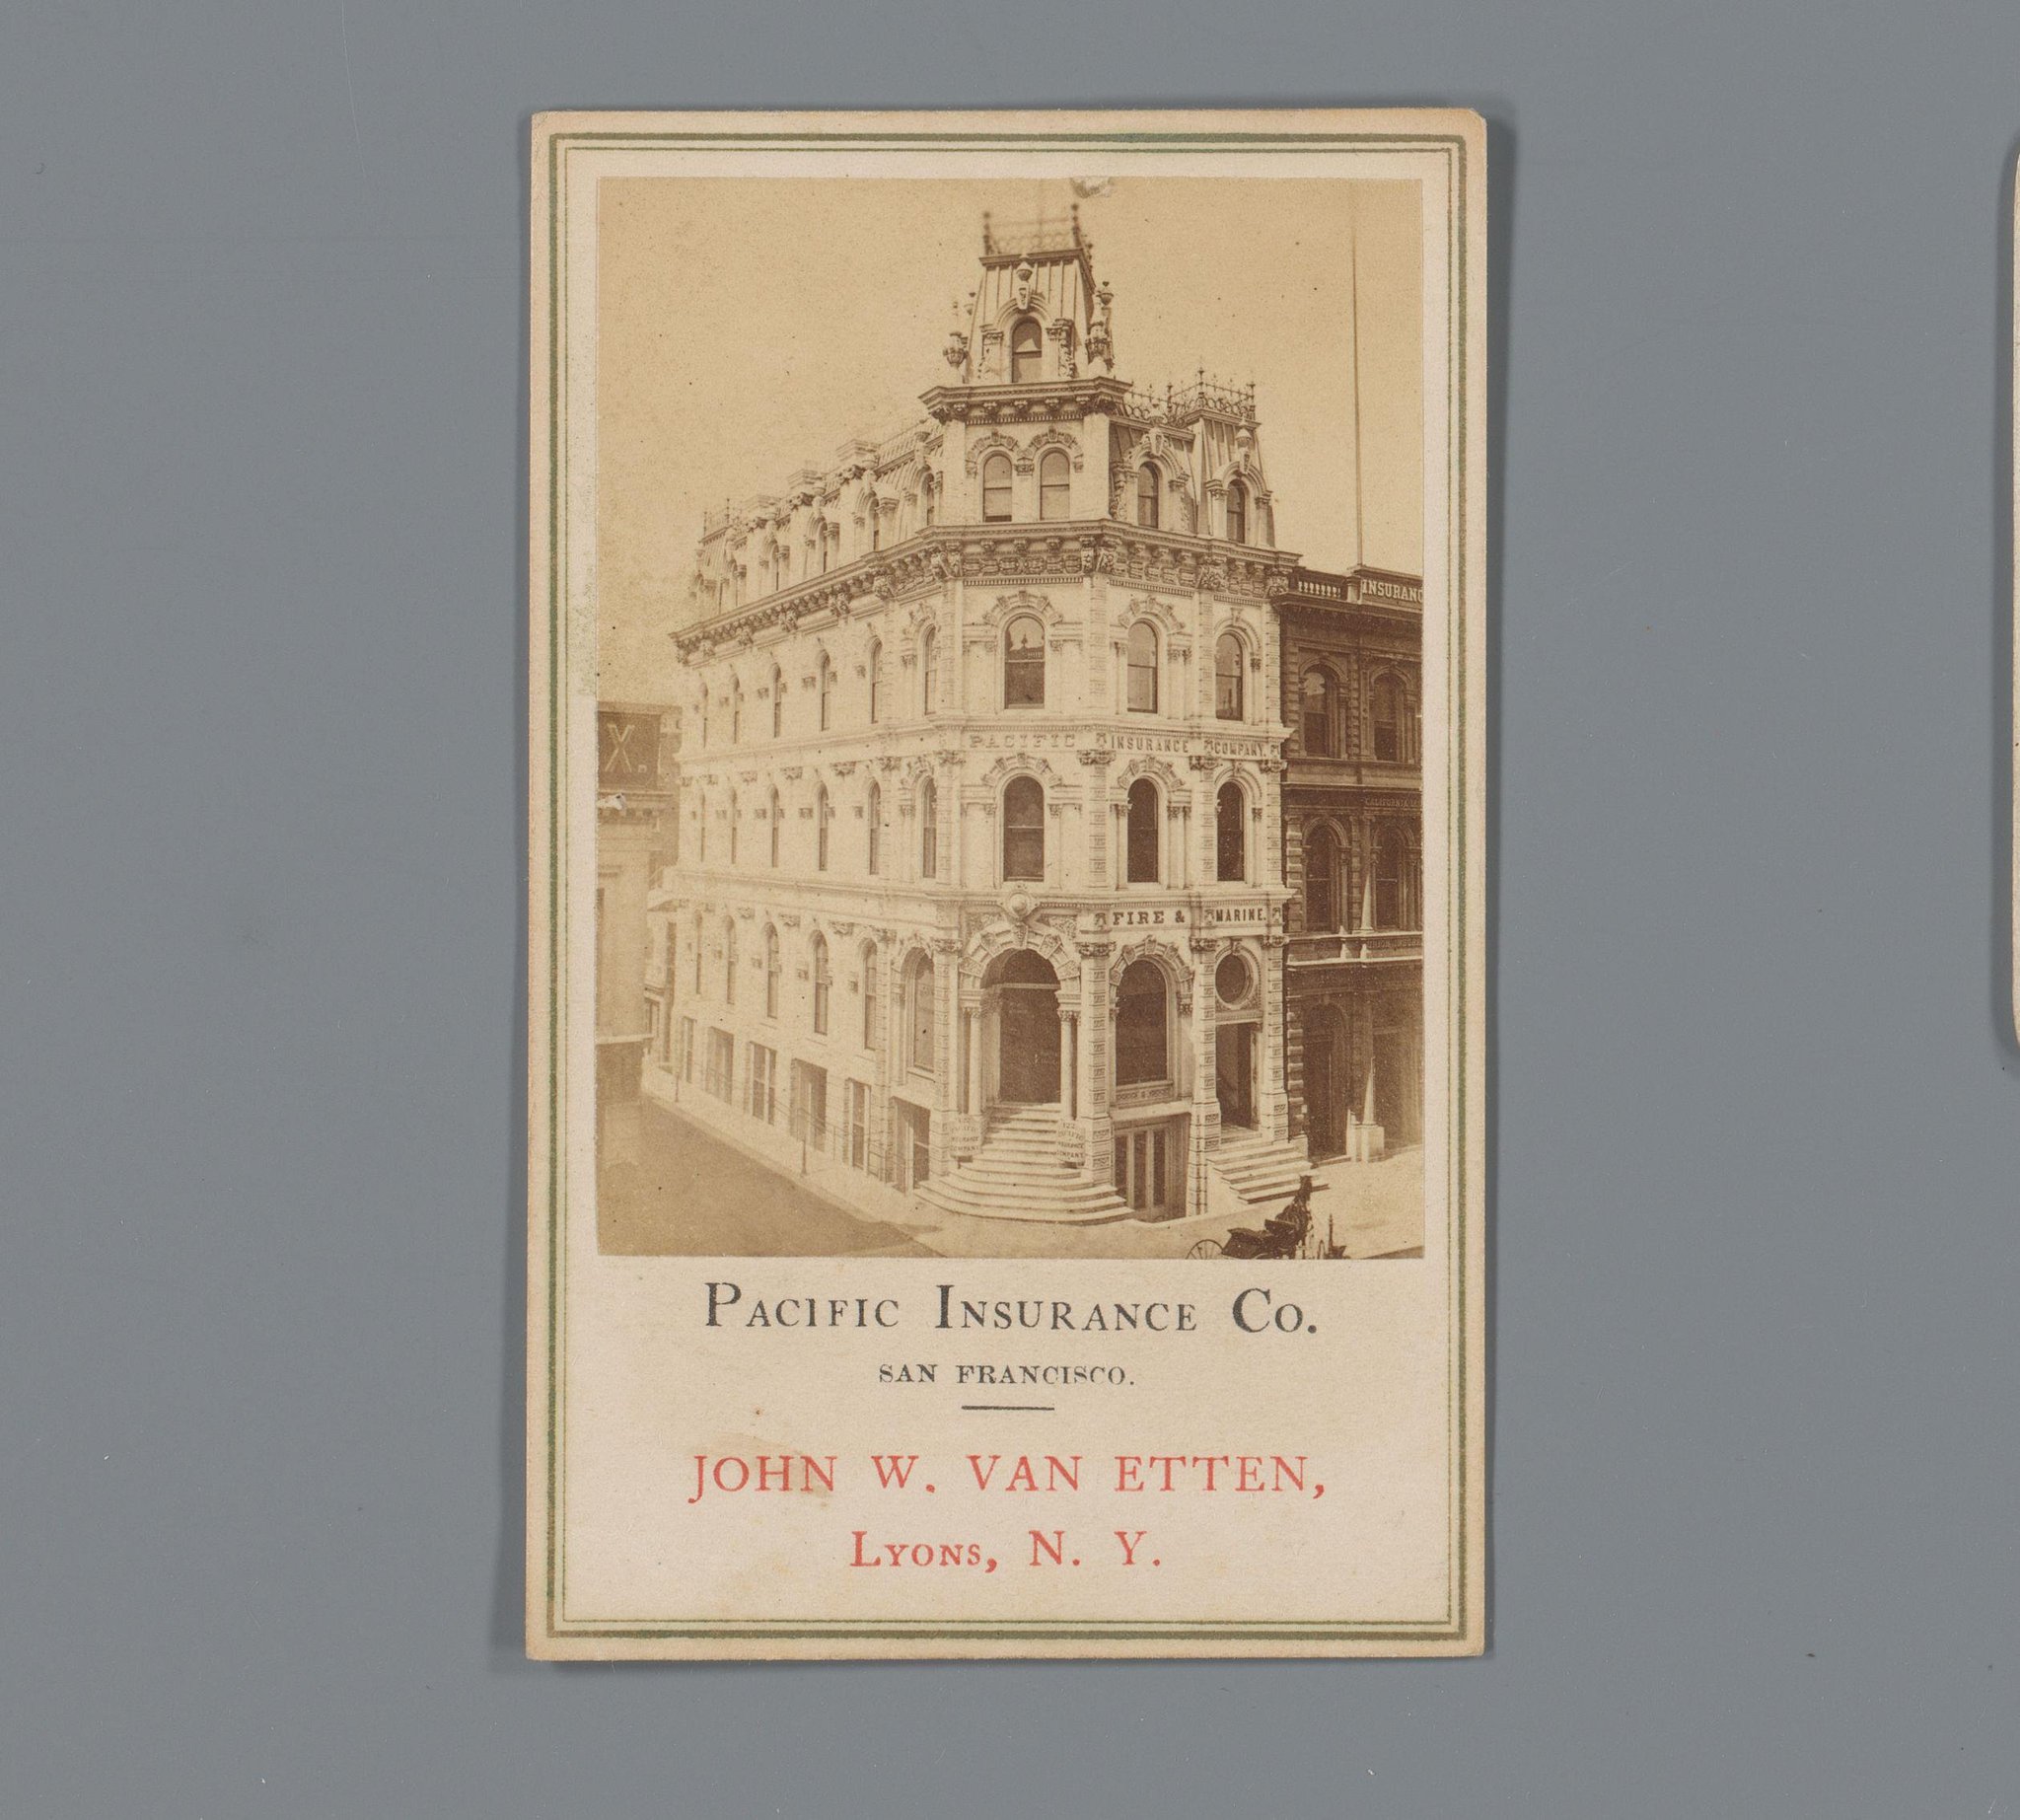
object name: carte de visite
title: Pacific Insurance Co.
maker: Anonymous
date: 1850-1915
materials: cardboard, photographic support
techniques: albumen print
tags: advertising, organization of trade and finance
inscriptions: inscription: ‘(...)’